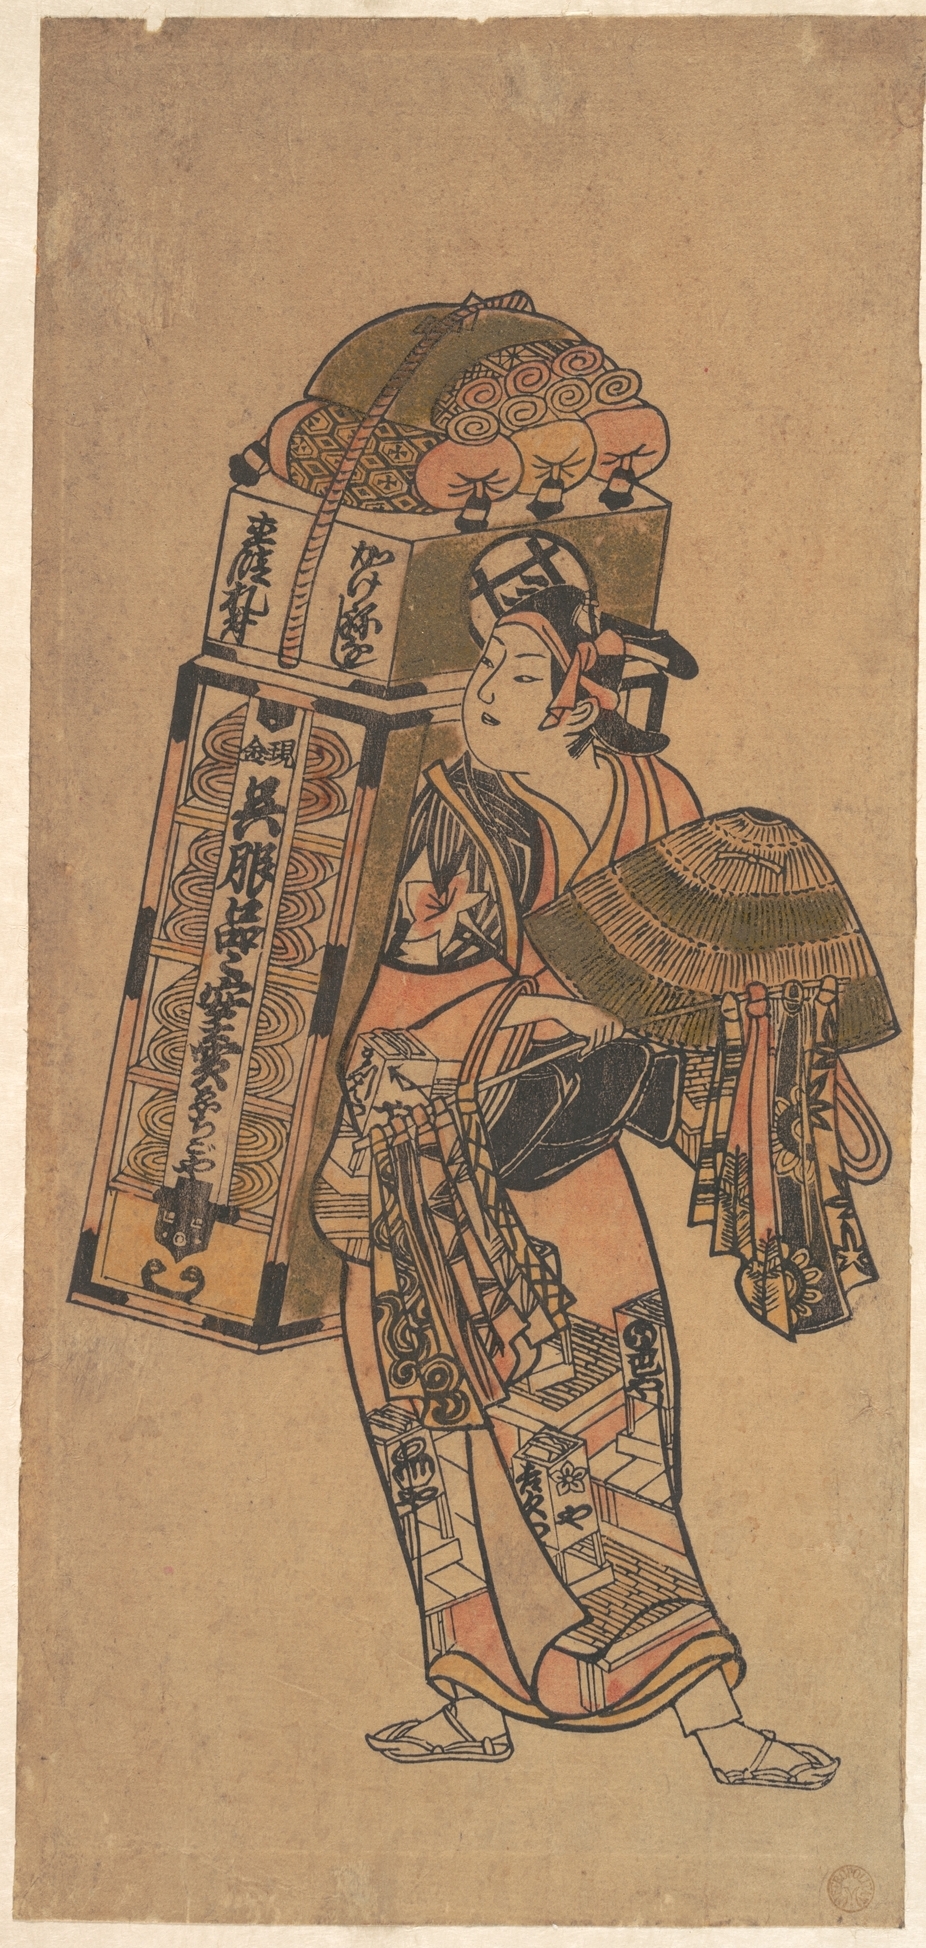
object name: print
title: Actor (unidentified) as a Peddler of Dry Goods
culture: japanese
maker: okumura toshinobu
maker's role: artist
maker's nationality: japanese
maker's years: 1717-1750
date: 1728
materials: ink, paper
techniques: urushi, woodblock print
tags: actors